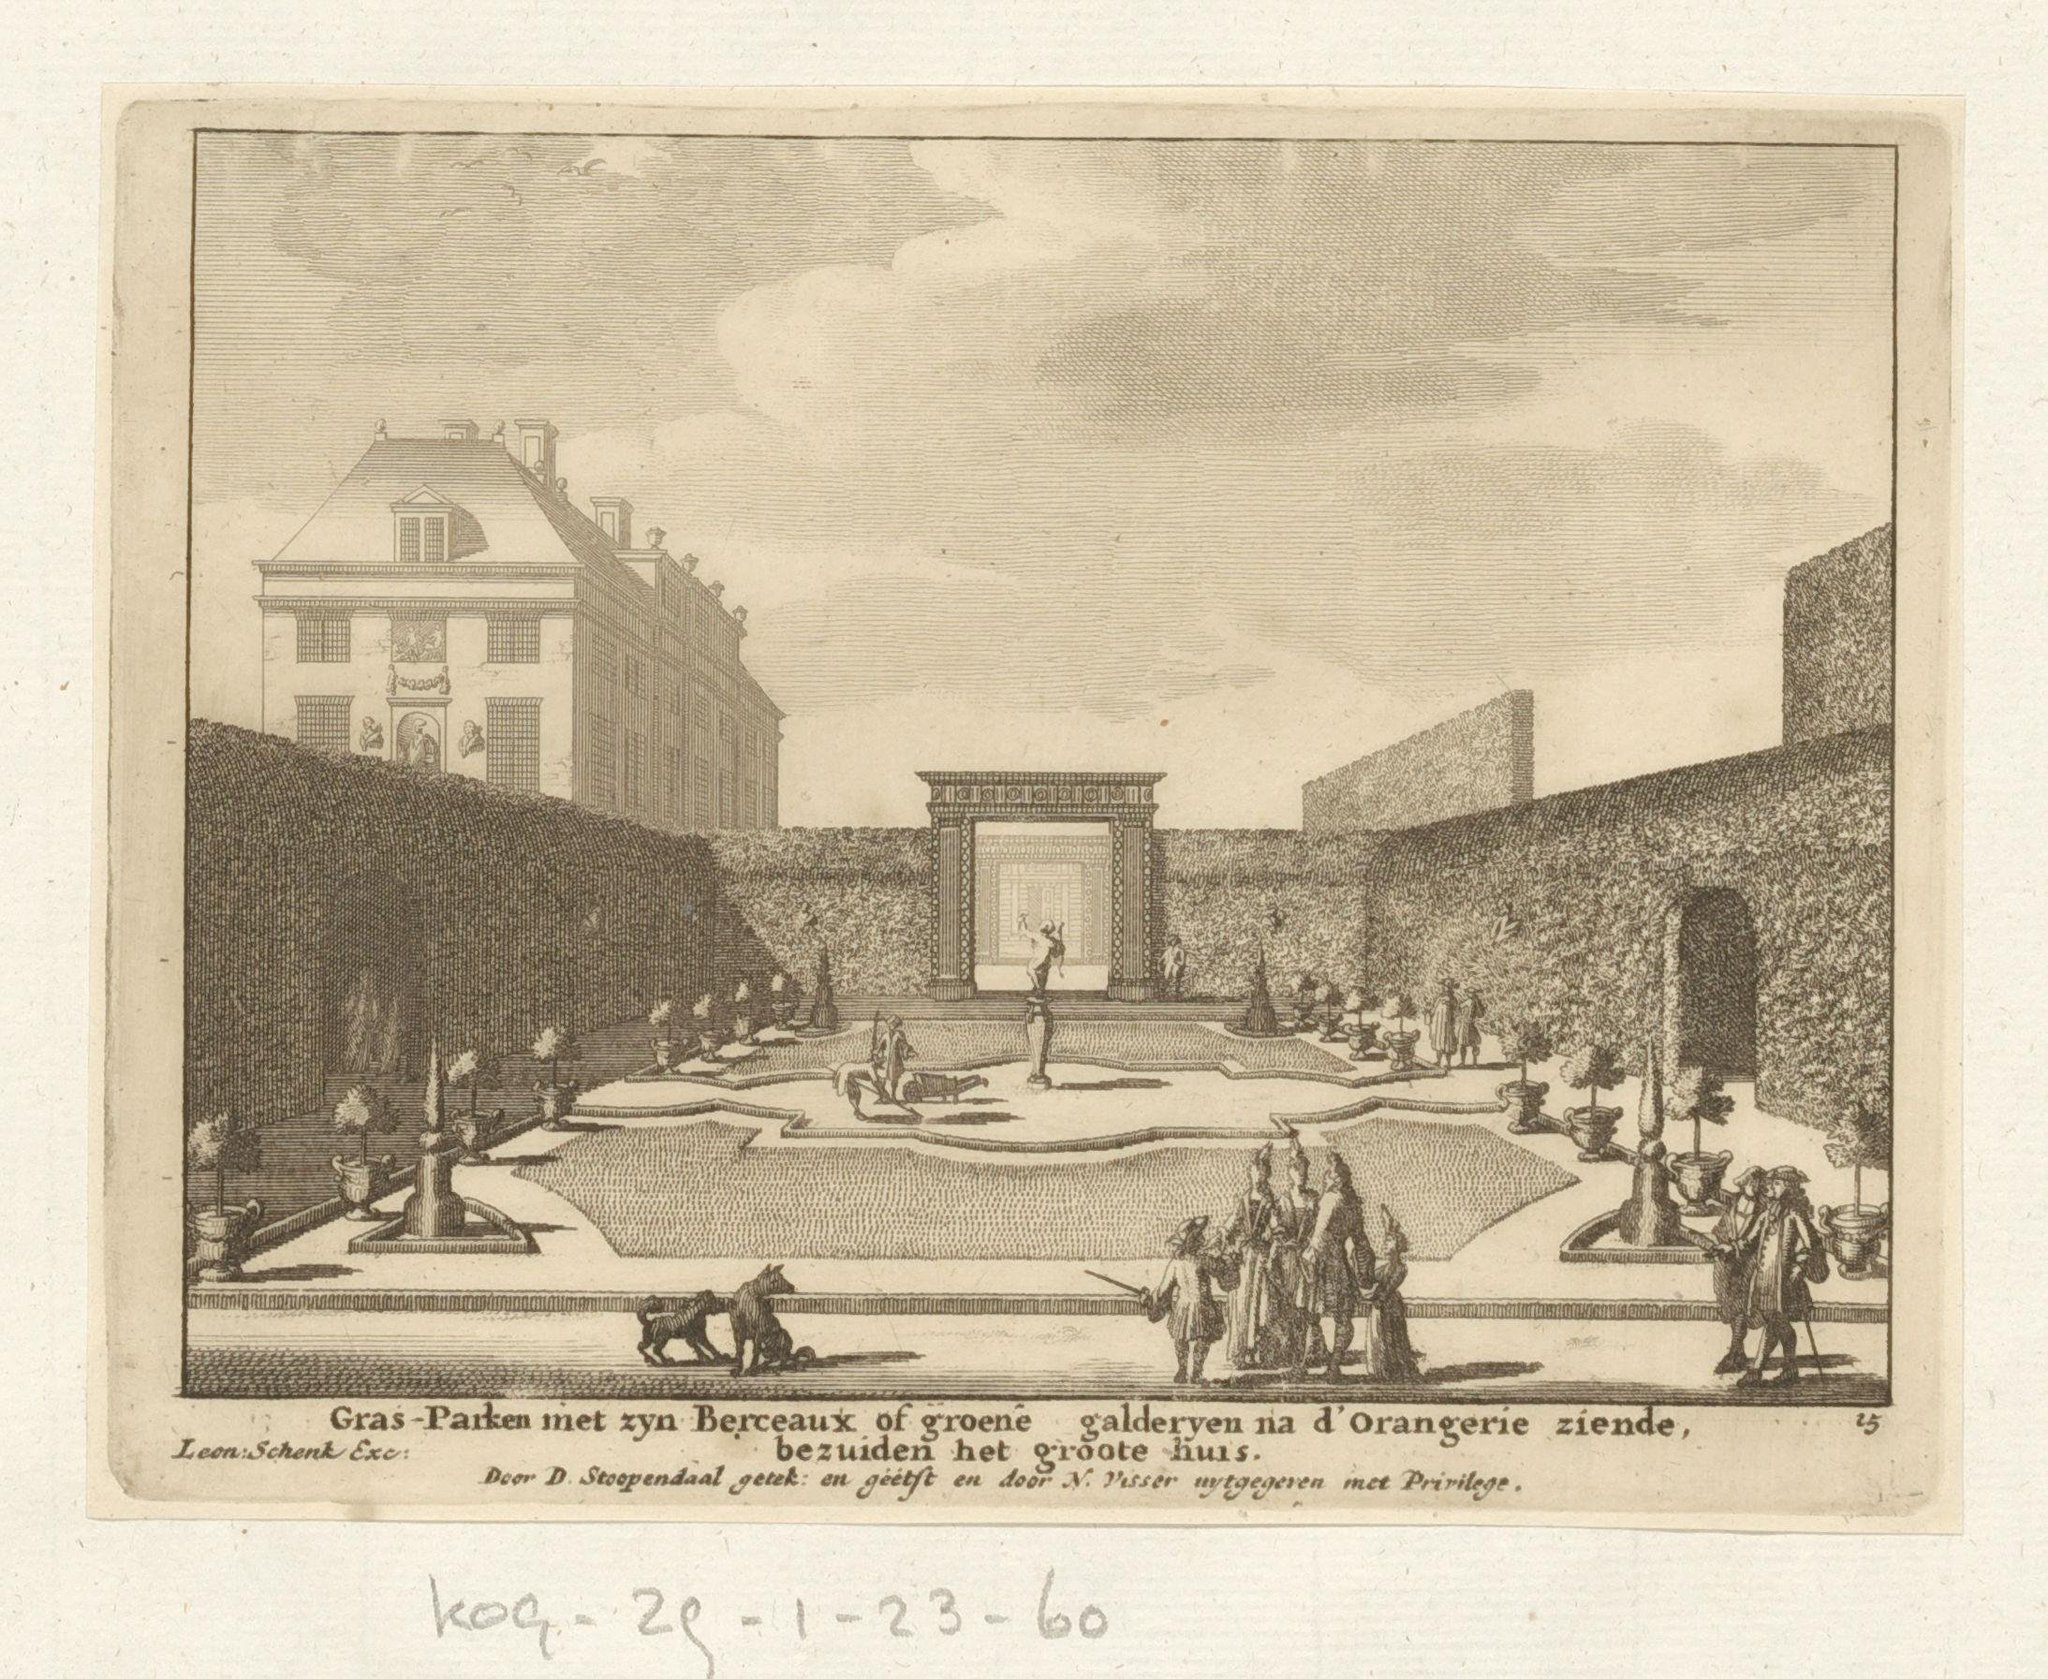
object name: print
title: Verscheyde schoone en vermaakelyke gezigten, in de Hofstede van Clingendaal gelegen by 's Gravenhage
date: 1706-1767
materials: paper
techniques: engraving, etching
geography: amsterdam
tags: french or architectonic garden; formal garden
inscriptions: stamp, collector's mark: Lugt 1641, stamp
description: Plattegrond van de eerste bloemperken met kleine fruitboompjes bij Huis Clingendael bij Den Haag. Onderwerpsrubrieken binnen de Atlas Zeden en Gewoonten: Zeden en Gewoonten in Engeren Zin, De Woning. Kastelen en buitenplaatsen. Holland.